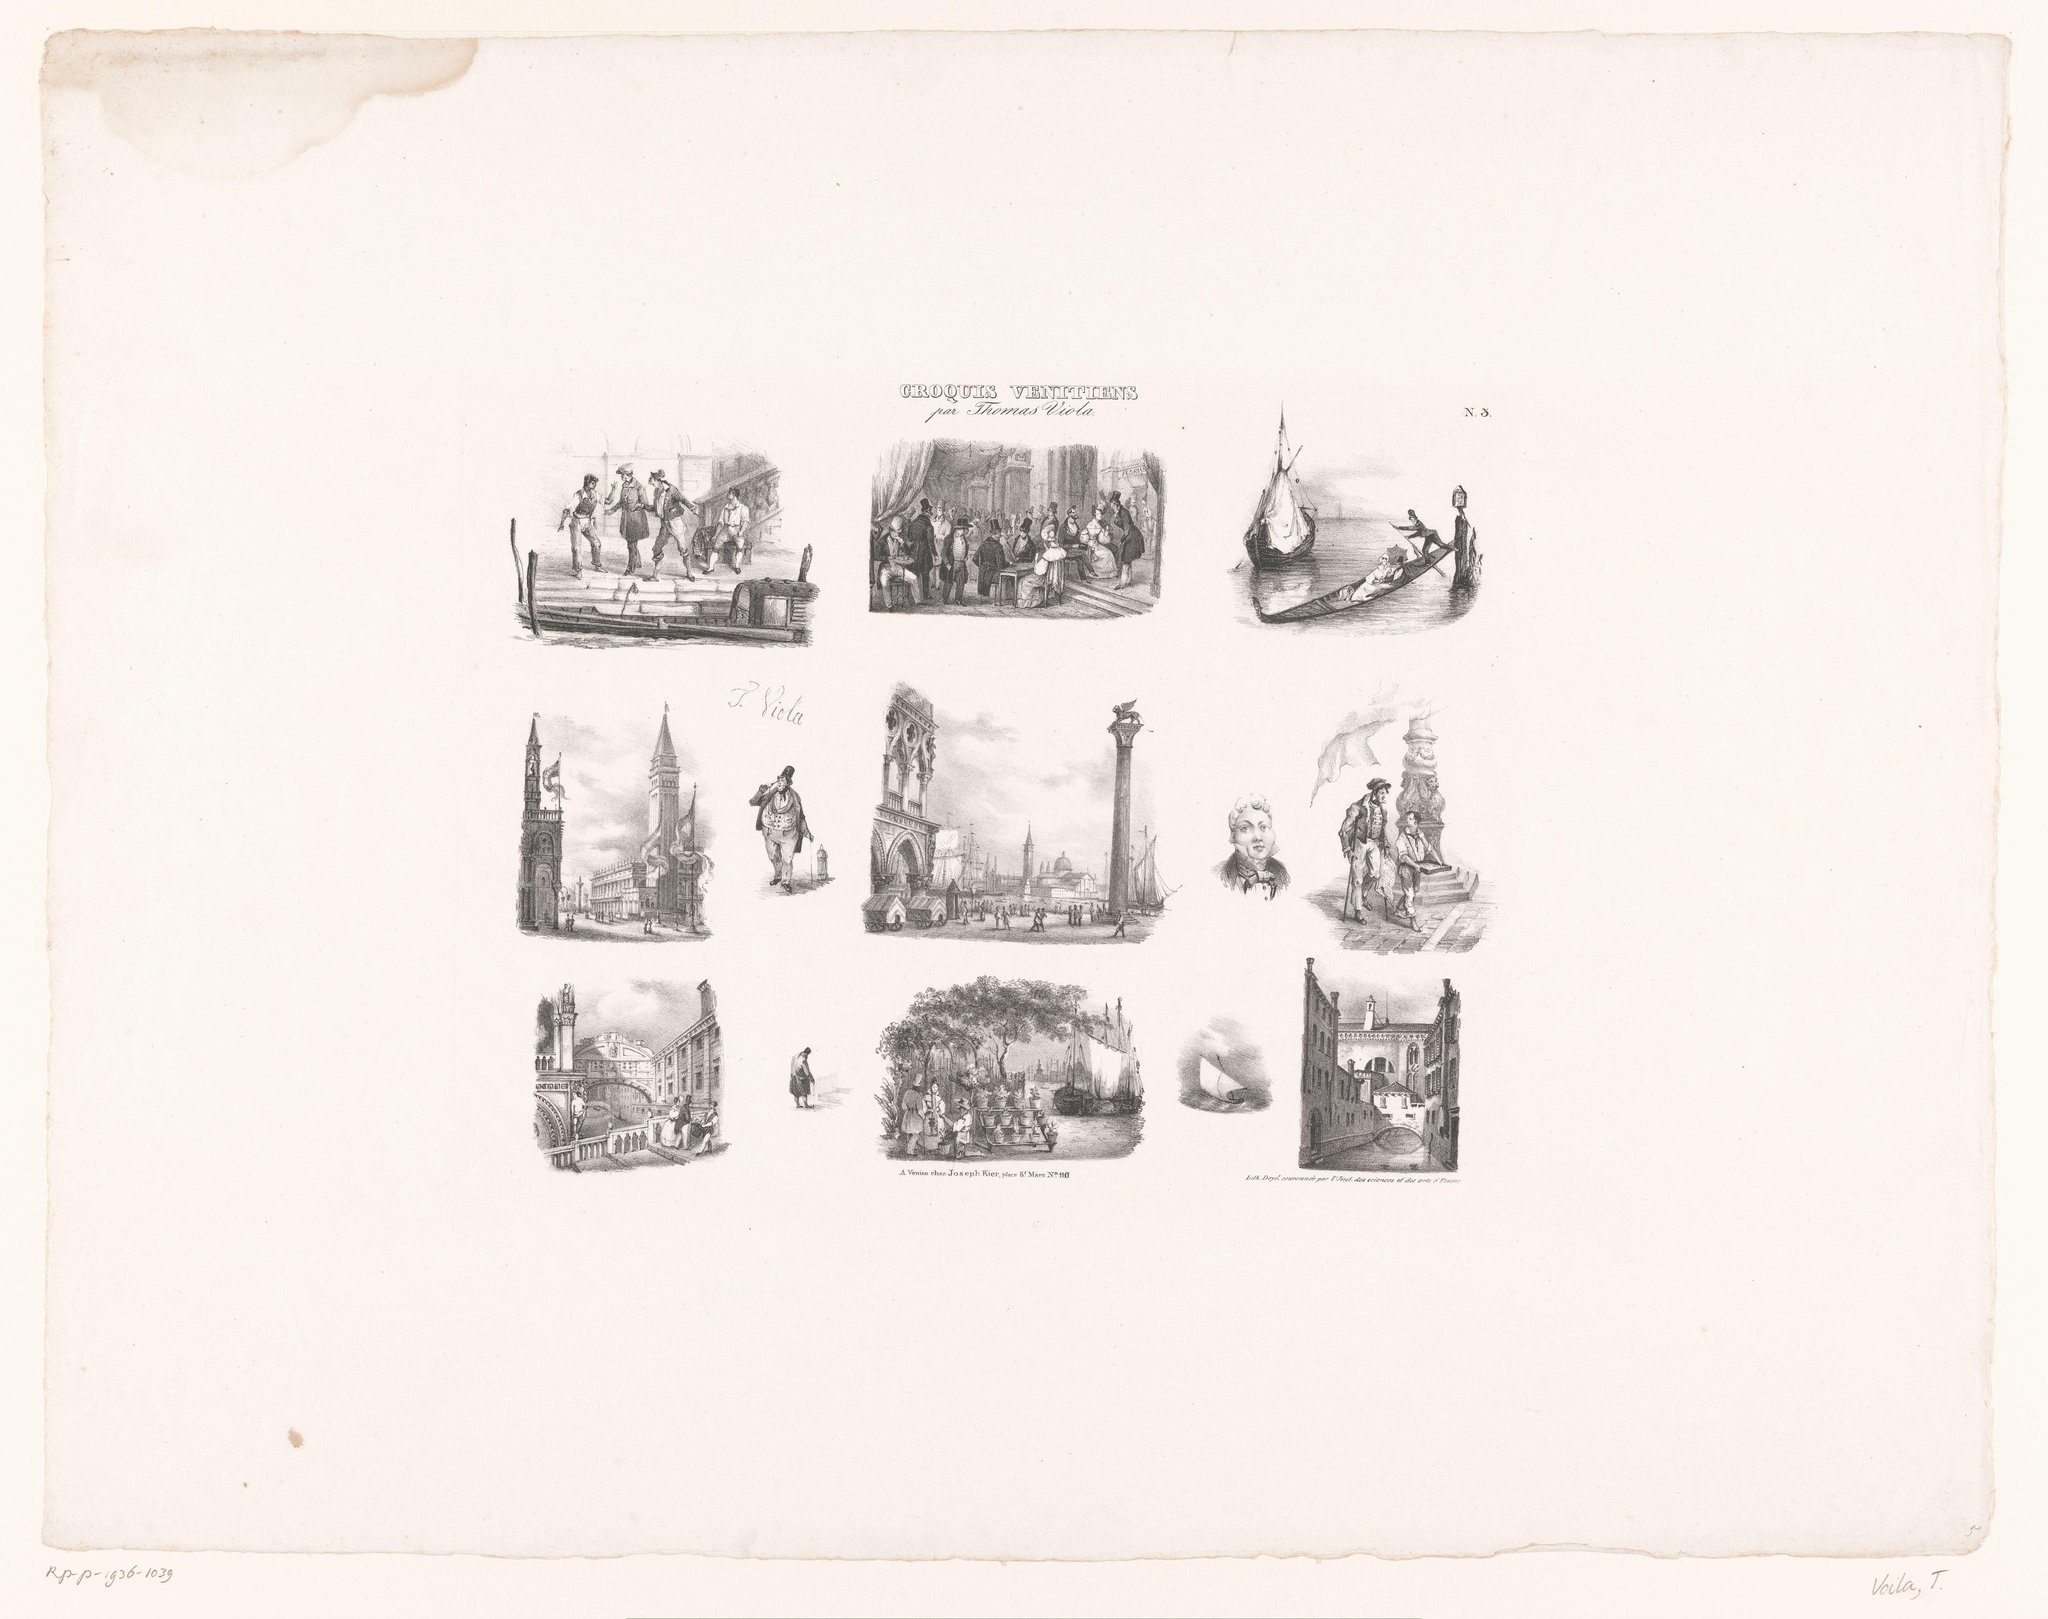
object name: print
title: Venetiaanse schetsen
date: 1833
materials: paper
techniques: lithograph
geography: venice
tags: canal, ships (in general), bridge, gondola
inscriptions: watermark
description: Prent met negen gezichten in de stad Venetië. Tussen de gezichten drie kleine portretten en een zeilboot.